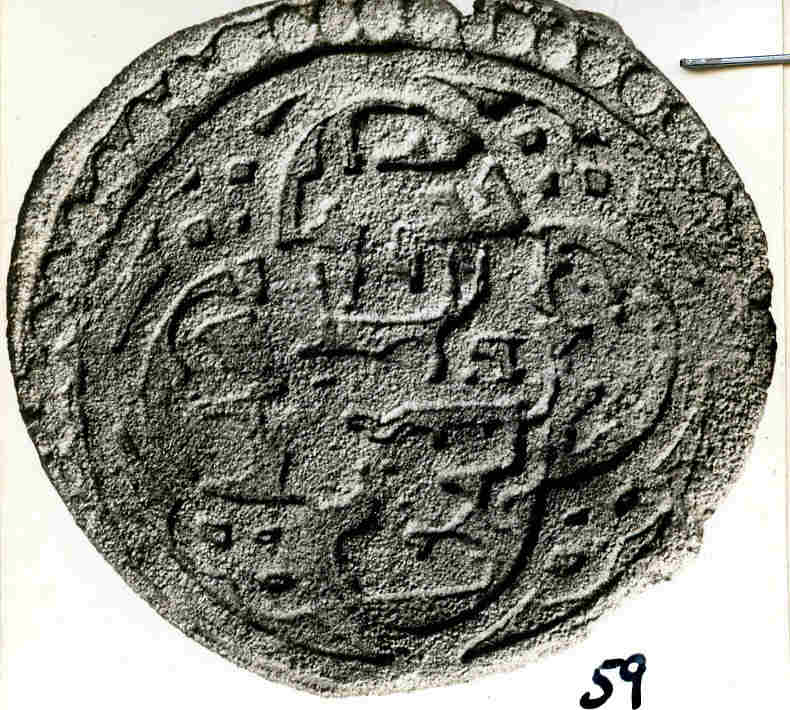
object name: coin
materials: copper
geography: iran